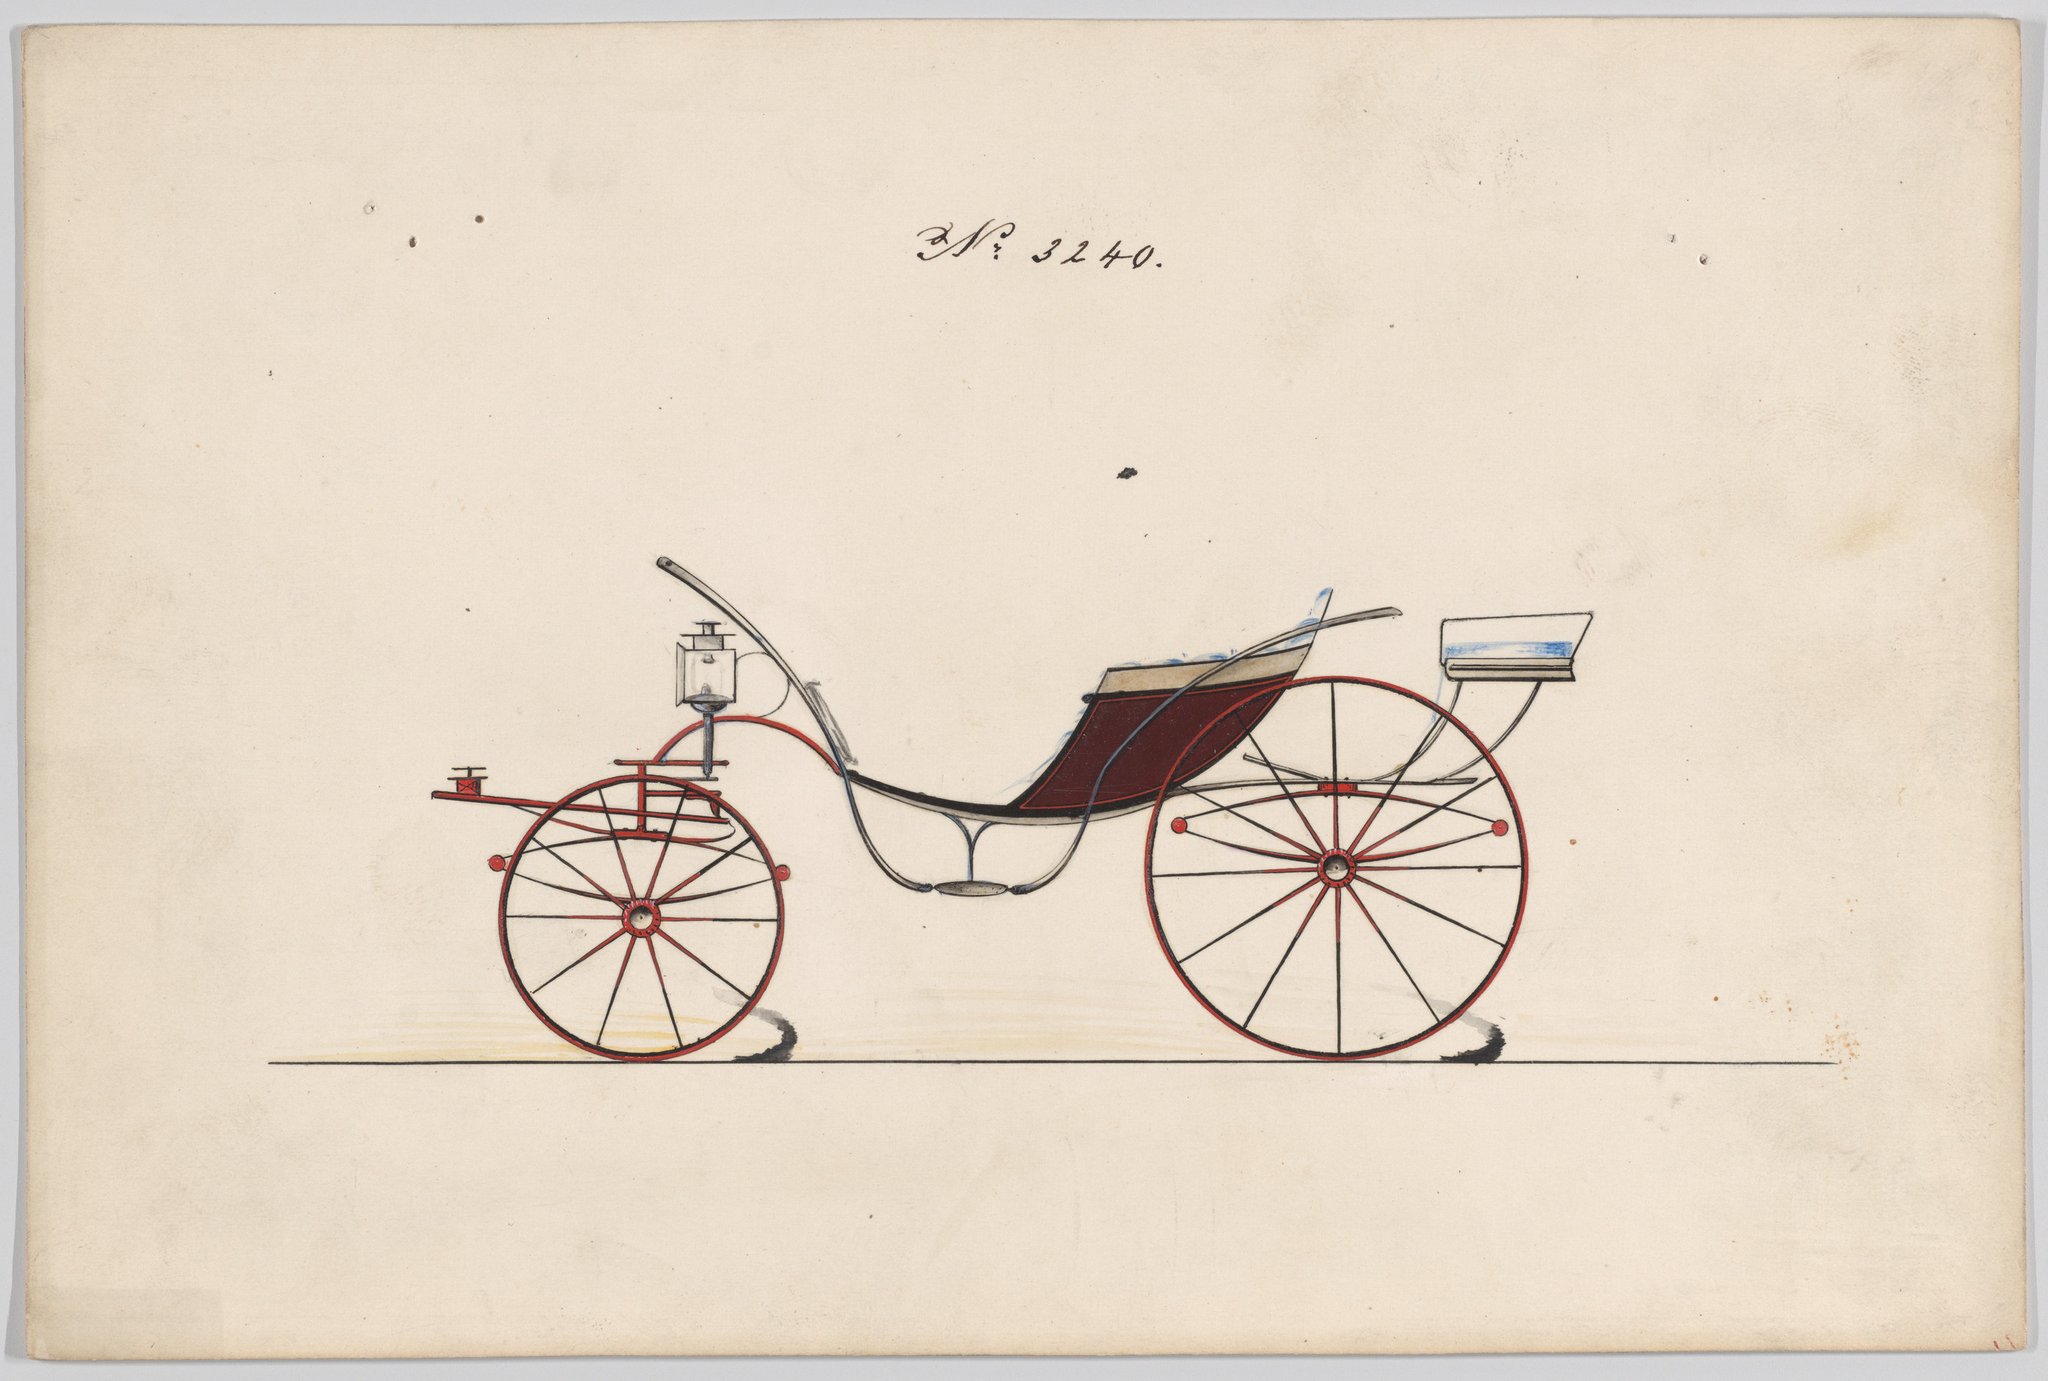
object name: drawing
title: Design for Pony Phaeton, no. 3240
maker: brewster & co.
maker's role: manufacturer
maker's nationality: american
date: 1876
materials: gouache, gum arabic, ink, watercolor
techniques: pen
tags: carriages